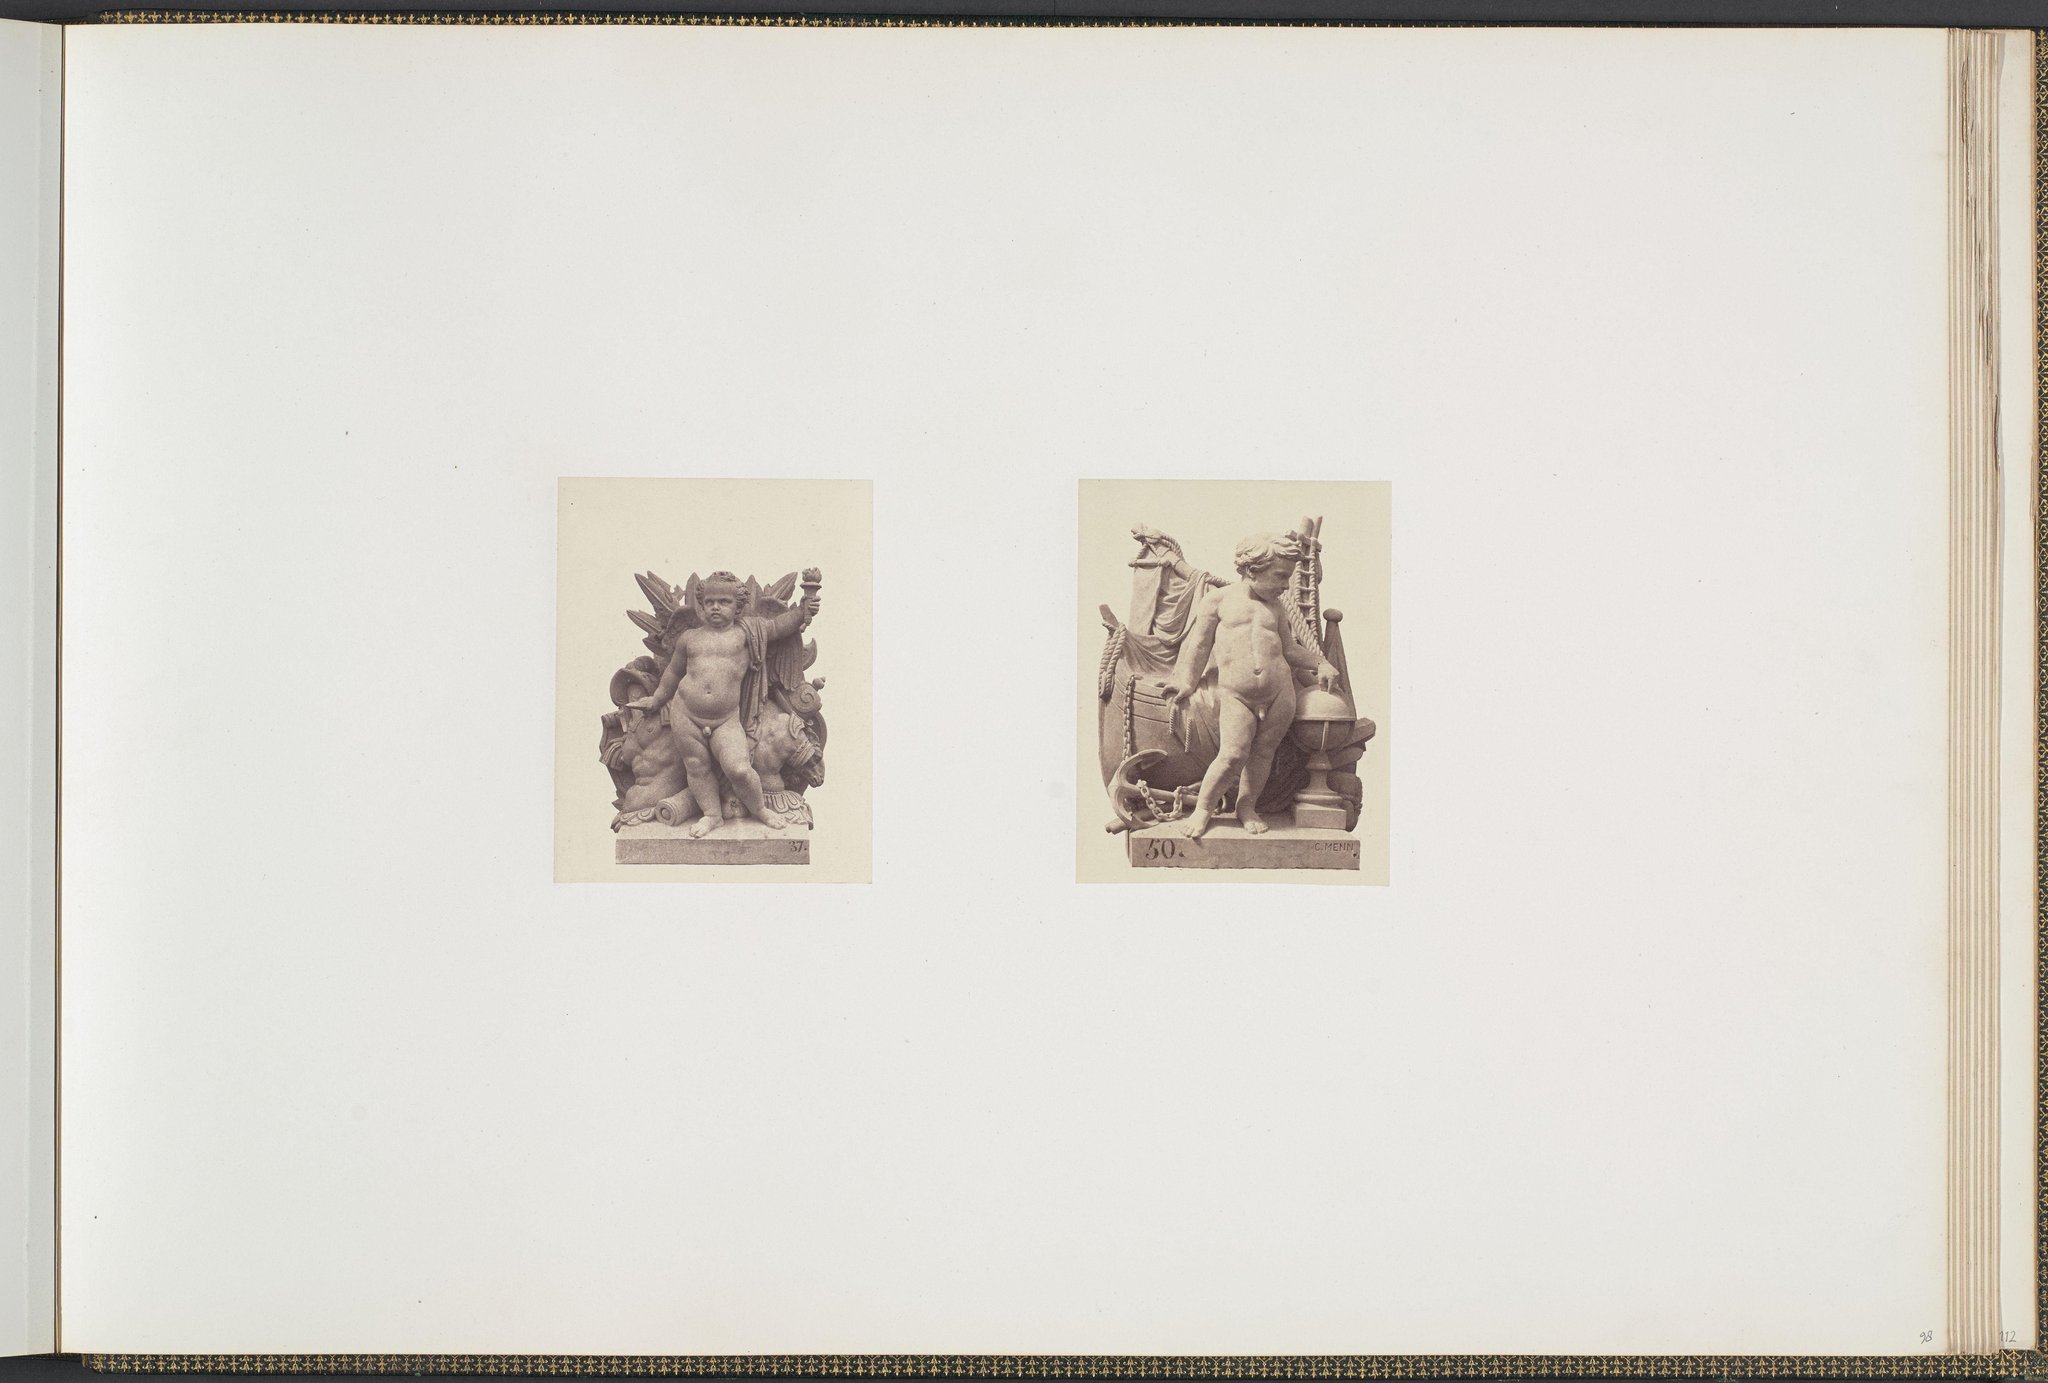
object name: photograph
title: Gipsmodellen voor beeldhouwwerken op het Palais du Louvre: links "La Guerre" door Edme Sornet en rechts "La Navigation" door Charles-Louis Menn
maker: édouard denis baldus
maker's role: fotograaf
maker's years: 1813-1889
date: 1855-1857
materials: paper, photographic support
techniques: salted paper print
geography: paris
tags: piece of sculpture, reproduction of a piece of sculpture, permanent exhibition, museum, paris, tuileries palace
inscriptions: number: ‘37 en 50’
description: Onderdeel van Réunion des Tuileries au Louvre 1852-1857, album 2.